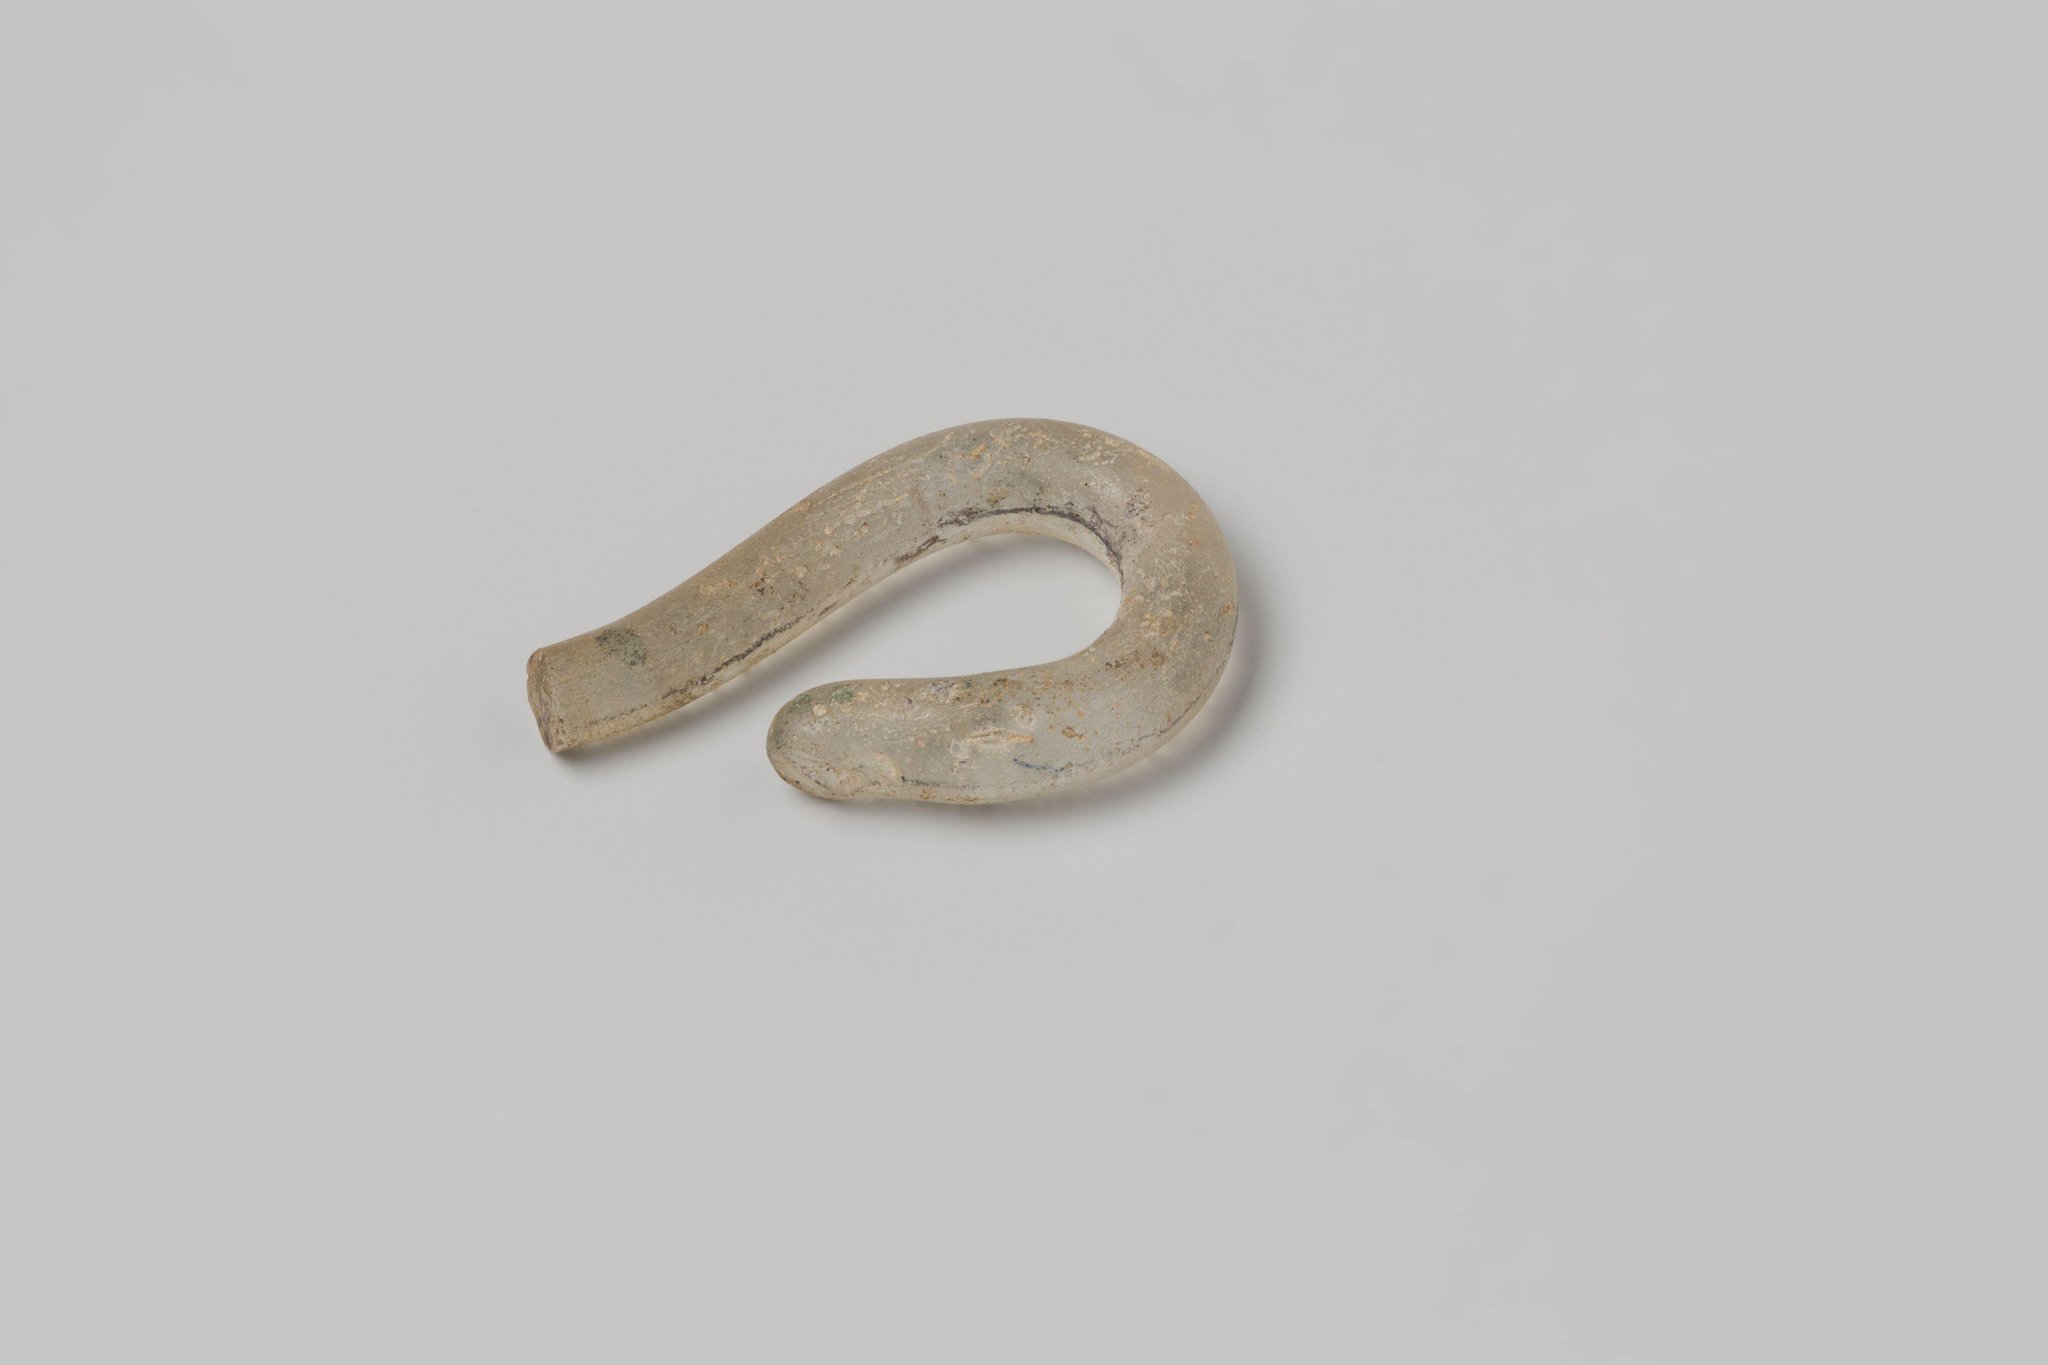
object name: vessel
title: Handvat van vaatwerk uit het wrak van de Oost-Indiëvaarder Hollandia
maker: Anonymous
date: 1700-1743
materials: glass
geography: netherlands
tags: verenigde oostindische compagnie, hollandia (schip), annet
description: Vessel part, handle; fragm, looped rod, lower end broken, circular in section.